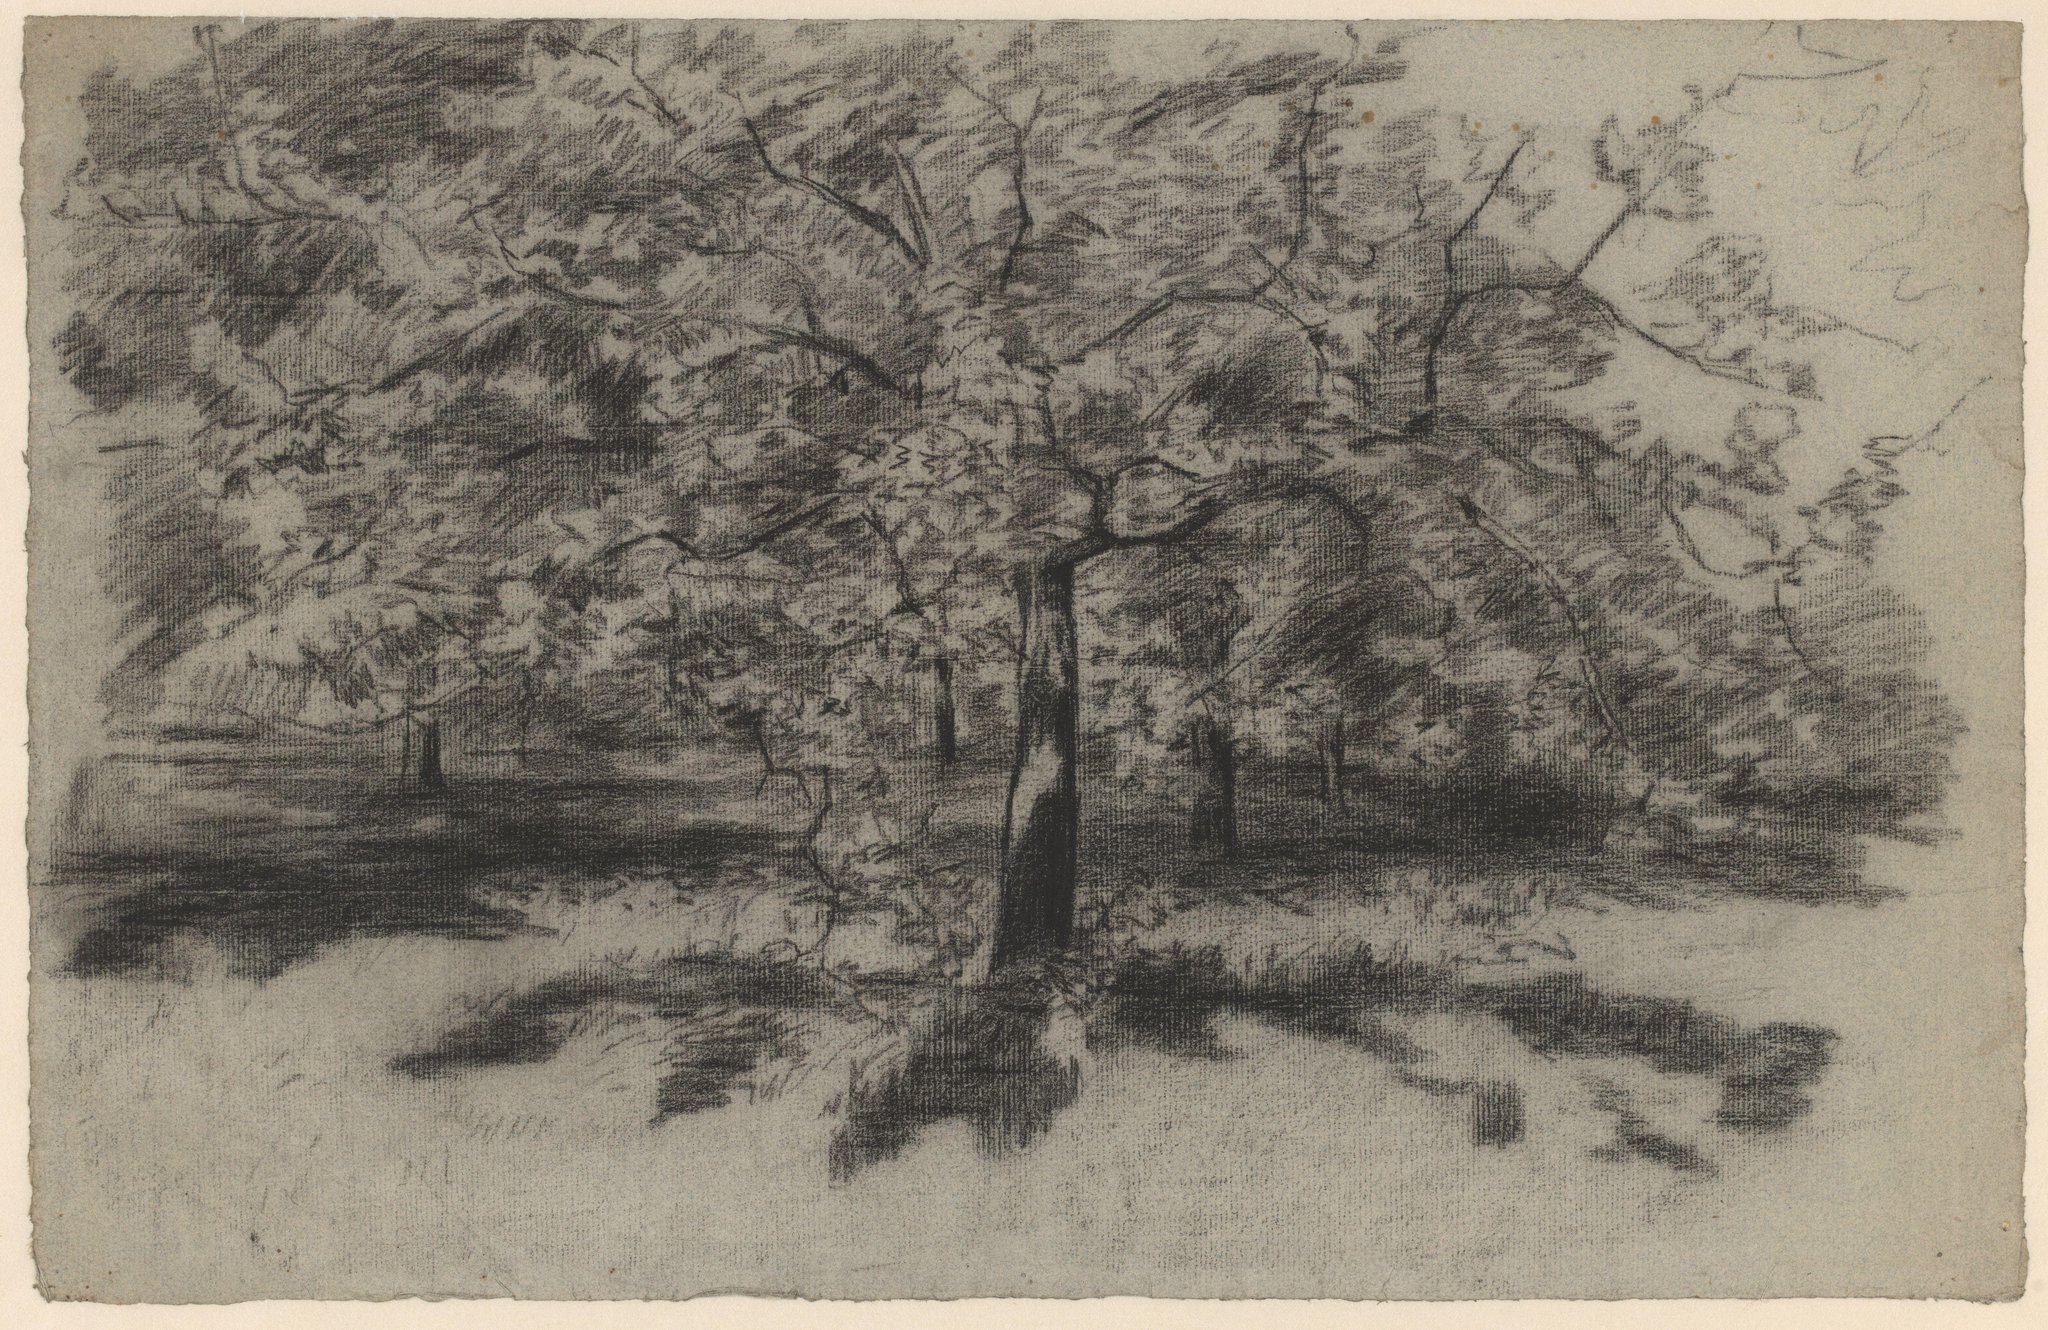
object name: drawing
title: Landschap met bomen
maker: egbert rubertus derk schaap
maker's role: draughtsman, painter, print maker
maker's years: 1862-1939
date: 1872-1939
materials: chalk, paper